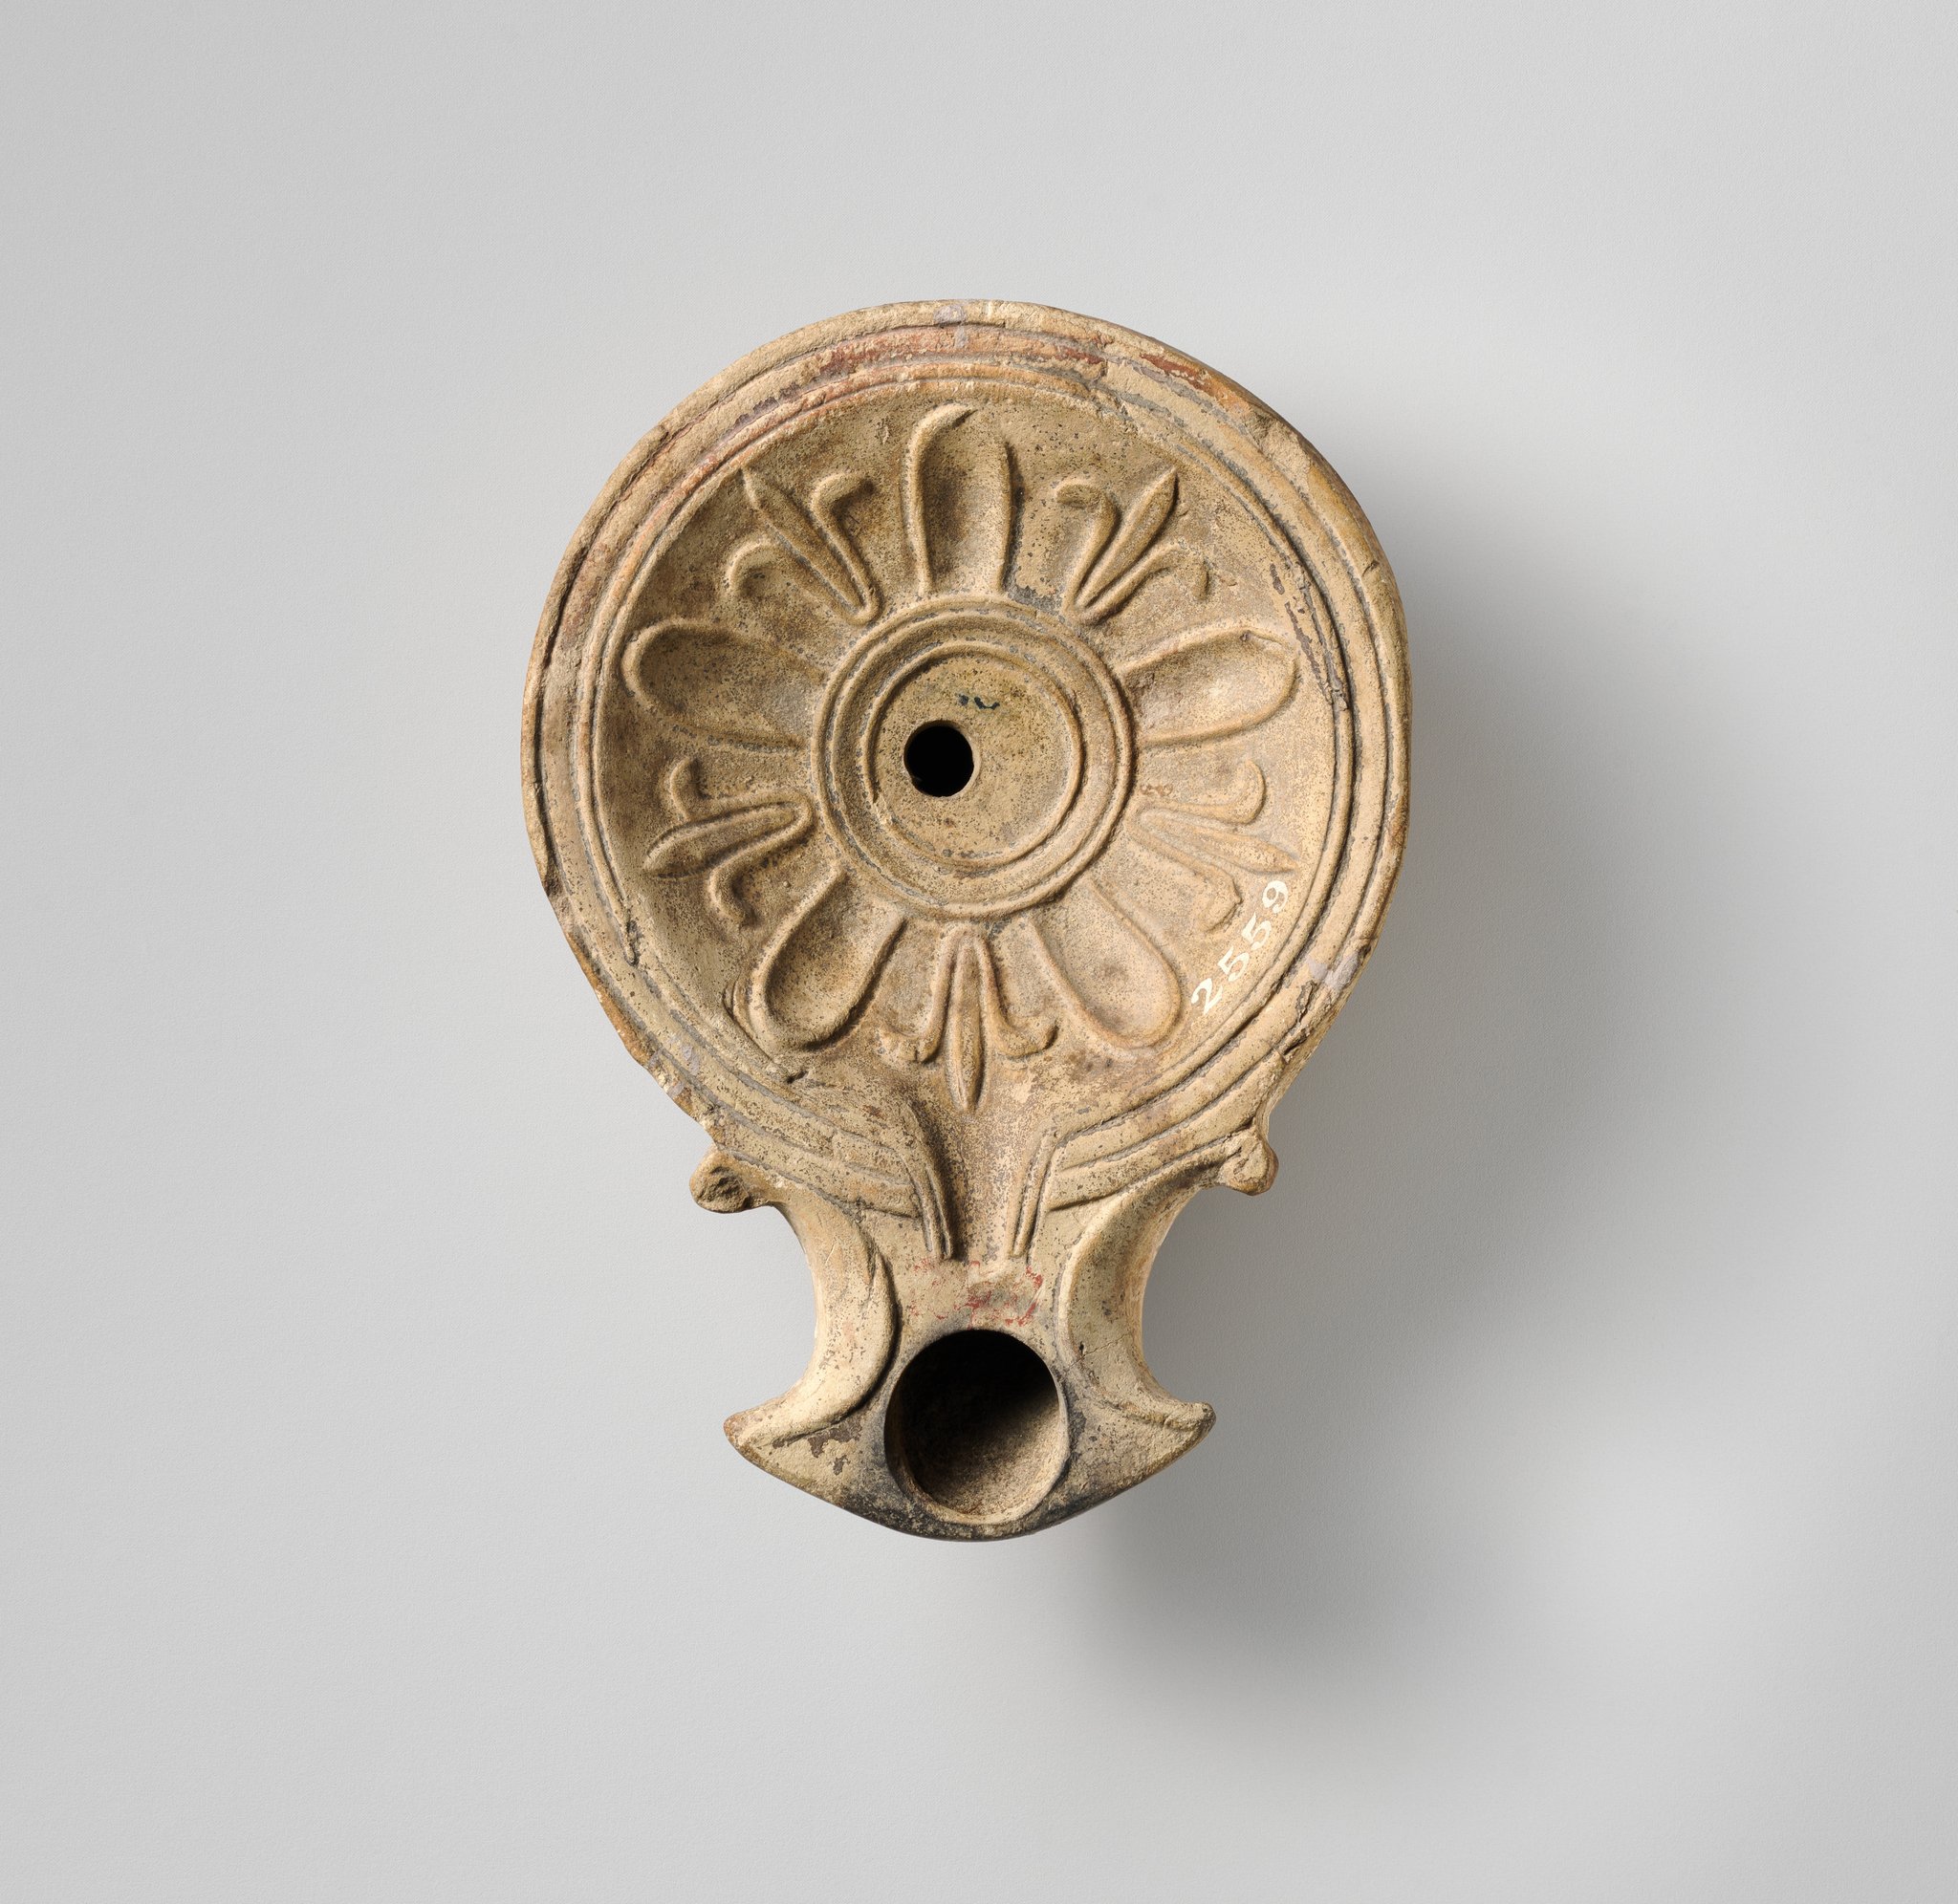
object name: lamp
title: Terracotta oil lamp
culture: roman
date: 100 BCE-100 CE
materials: terracotta